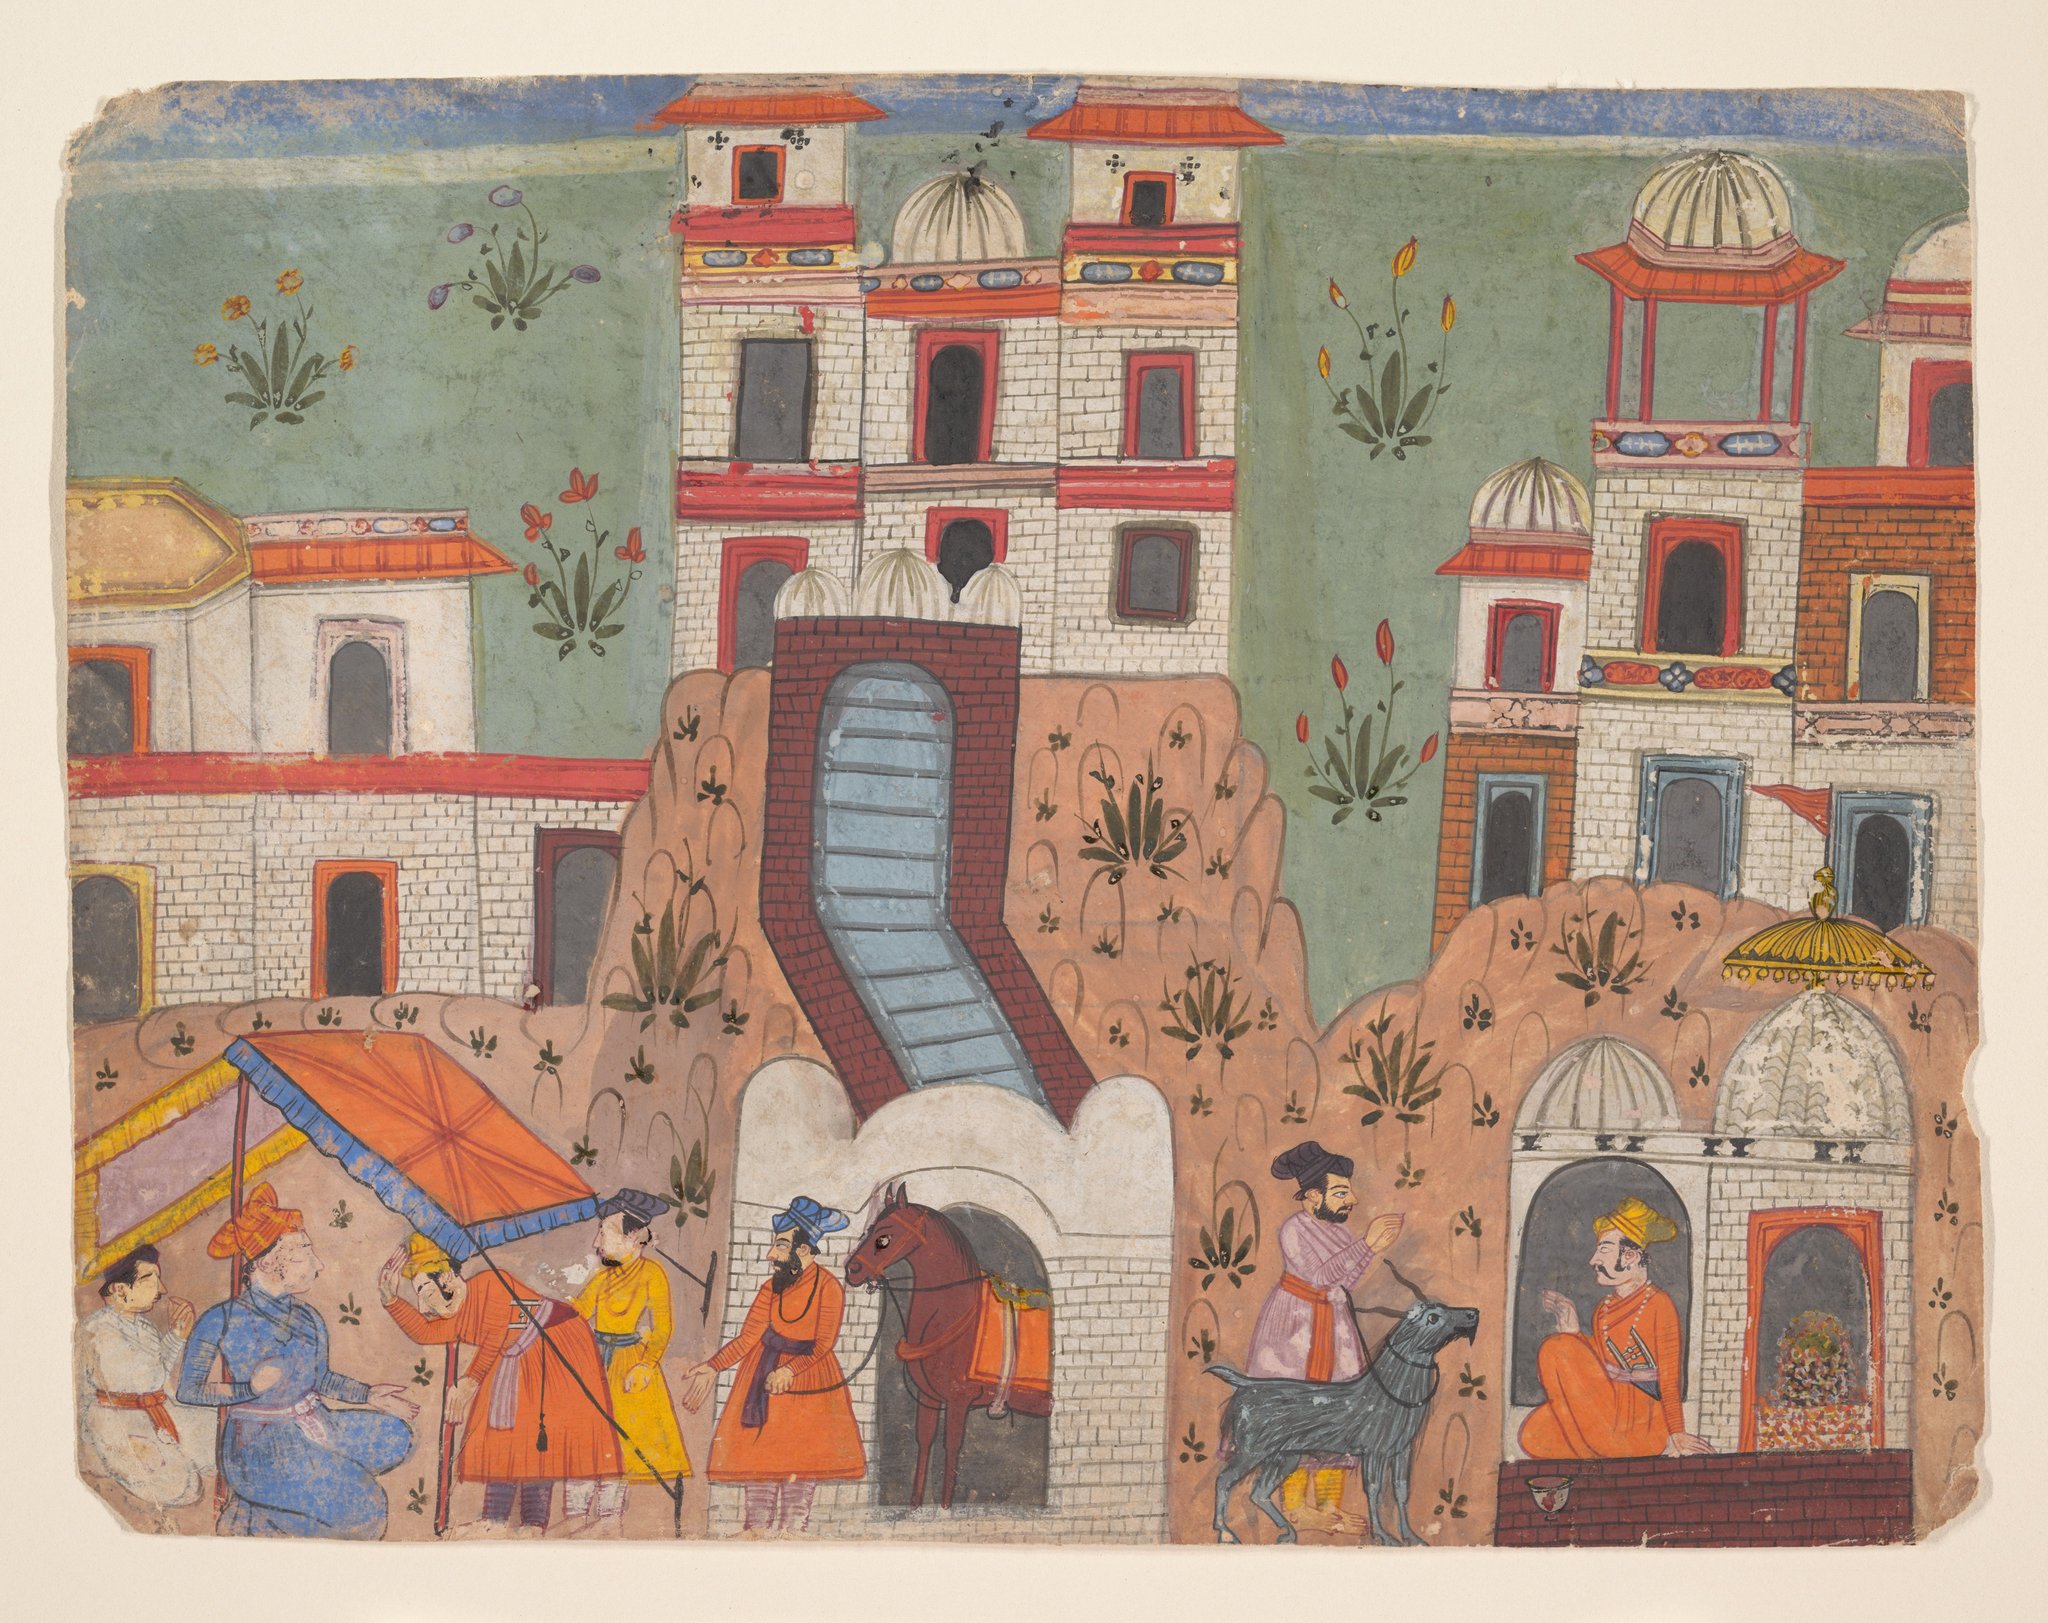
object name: folio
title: A Raja Receives Homage Outside the City: Page from a Dispersed Manuscript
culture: indian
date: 1676-1700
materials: ink, paper, watercolor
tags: buildings,cities,kings,men,goats,horses